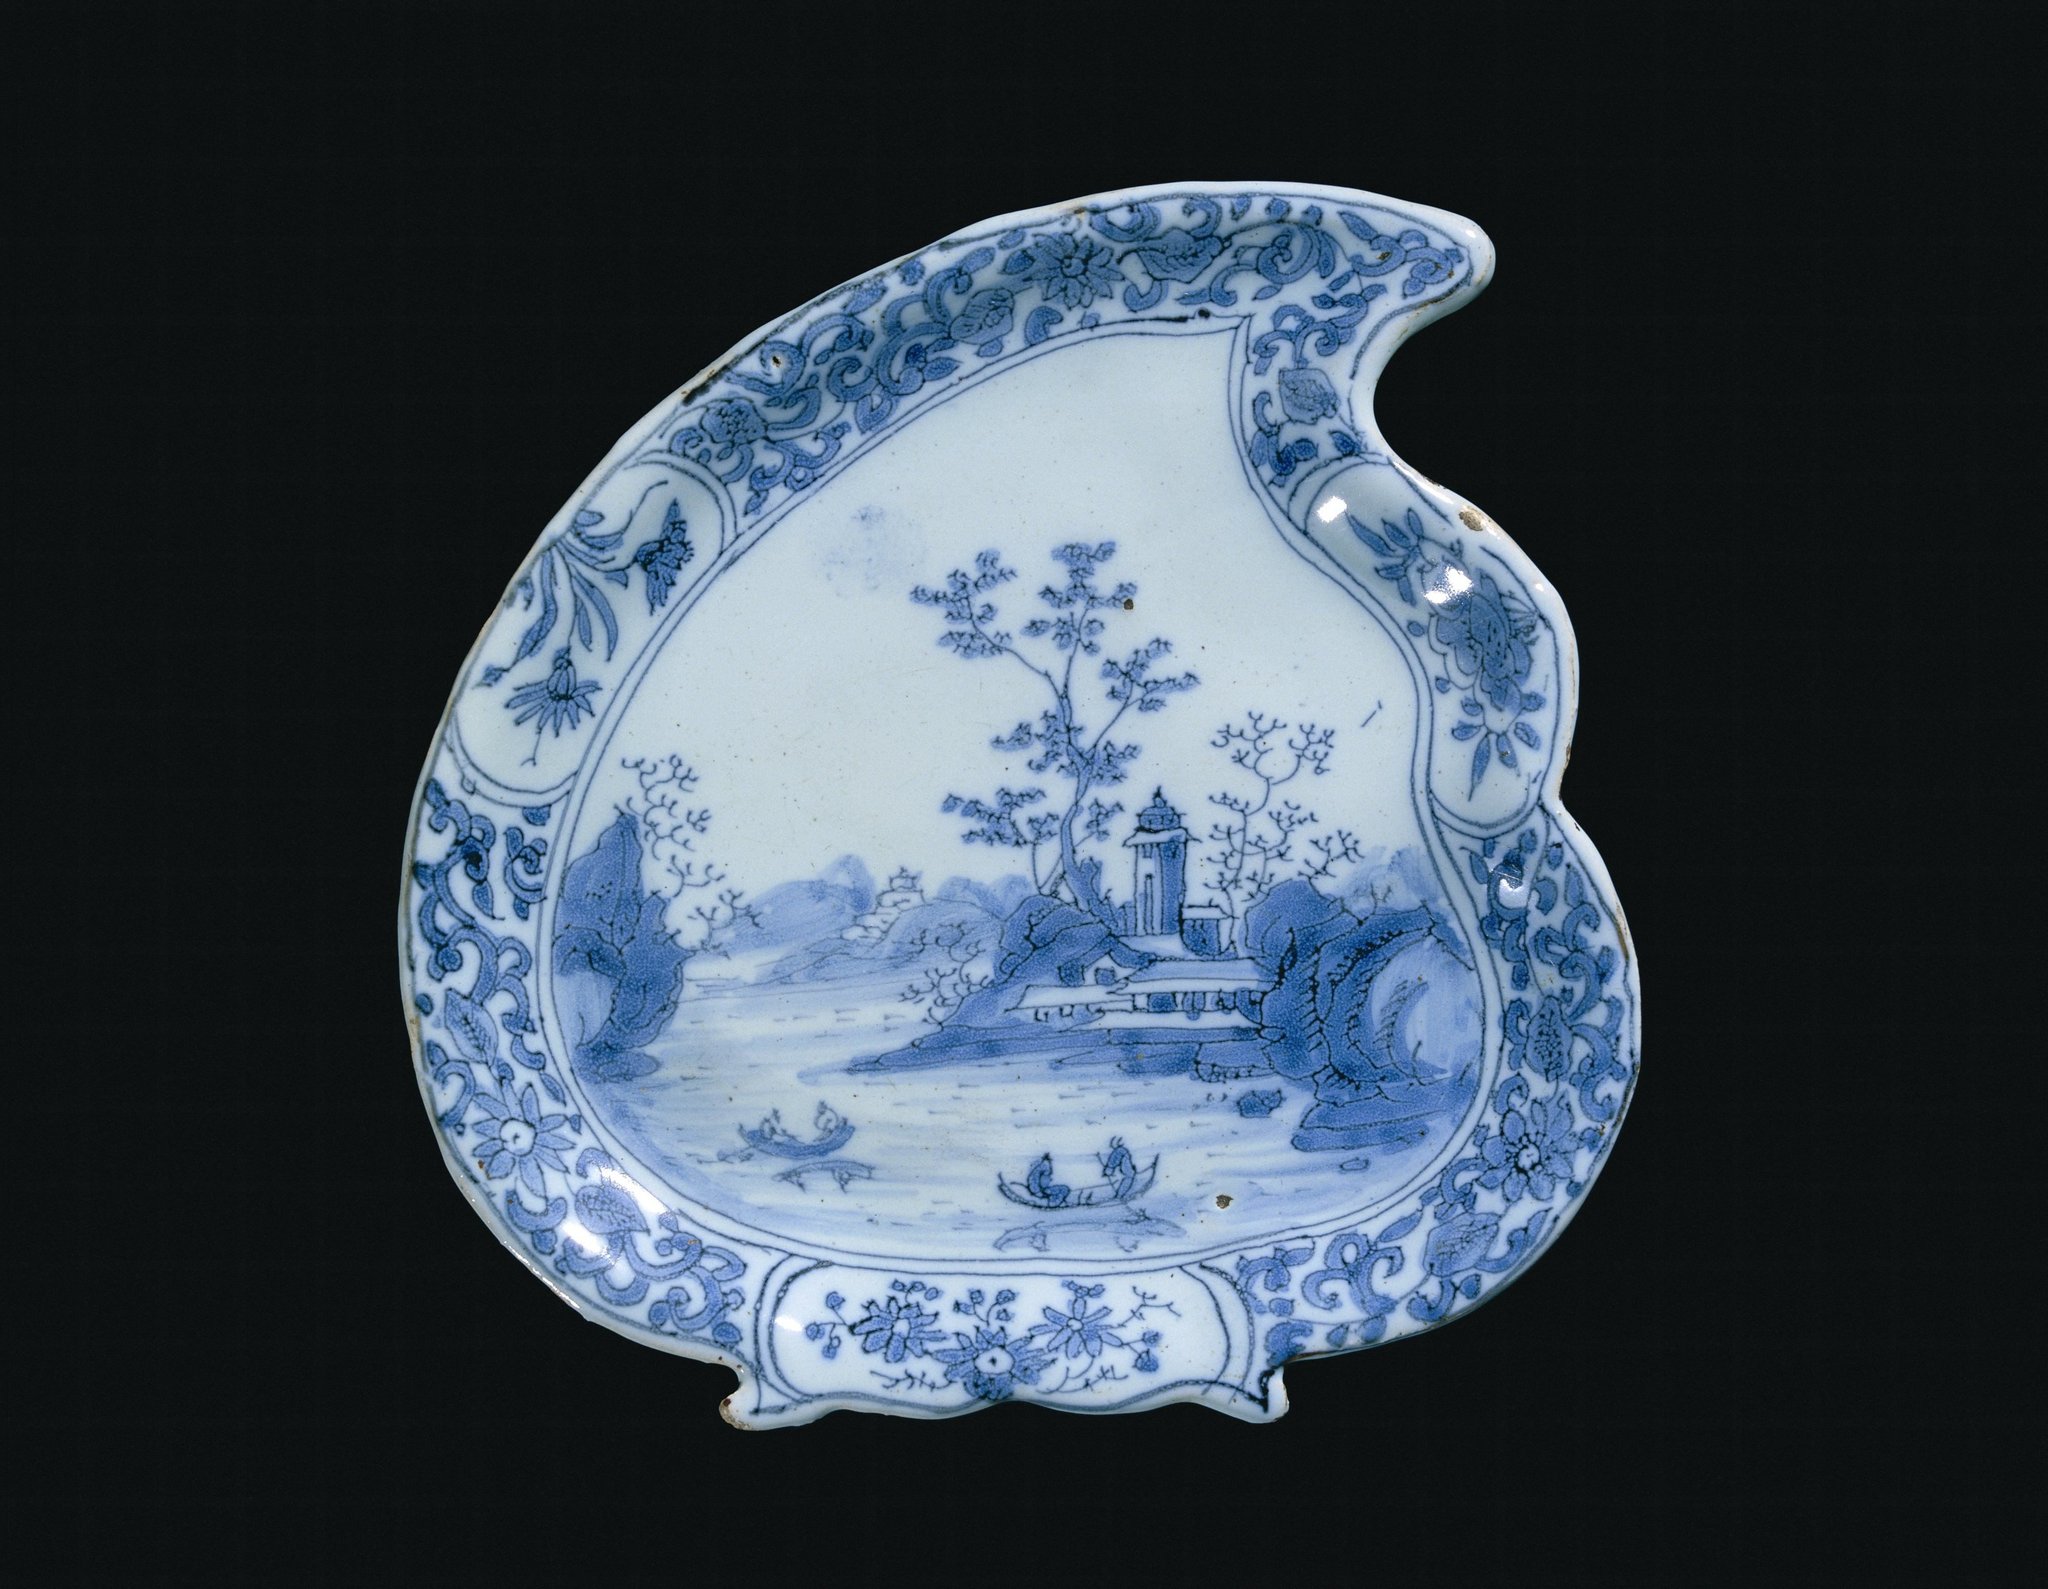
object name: dish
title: Dish in the shape of a peach leaf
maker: samuel van eenhoorn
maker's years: 1655-1687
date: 1678-1686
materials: earthenware, glaze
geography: delft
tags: river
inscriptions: mark: ‘SVE/ 18’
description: Schaal van faience met een chinoiserie decoratie geïnspireerd op het Chinese overgangsporselein